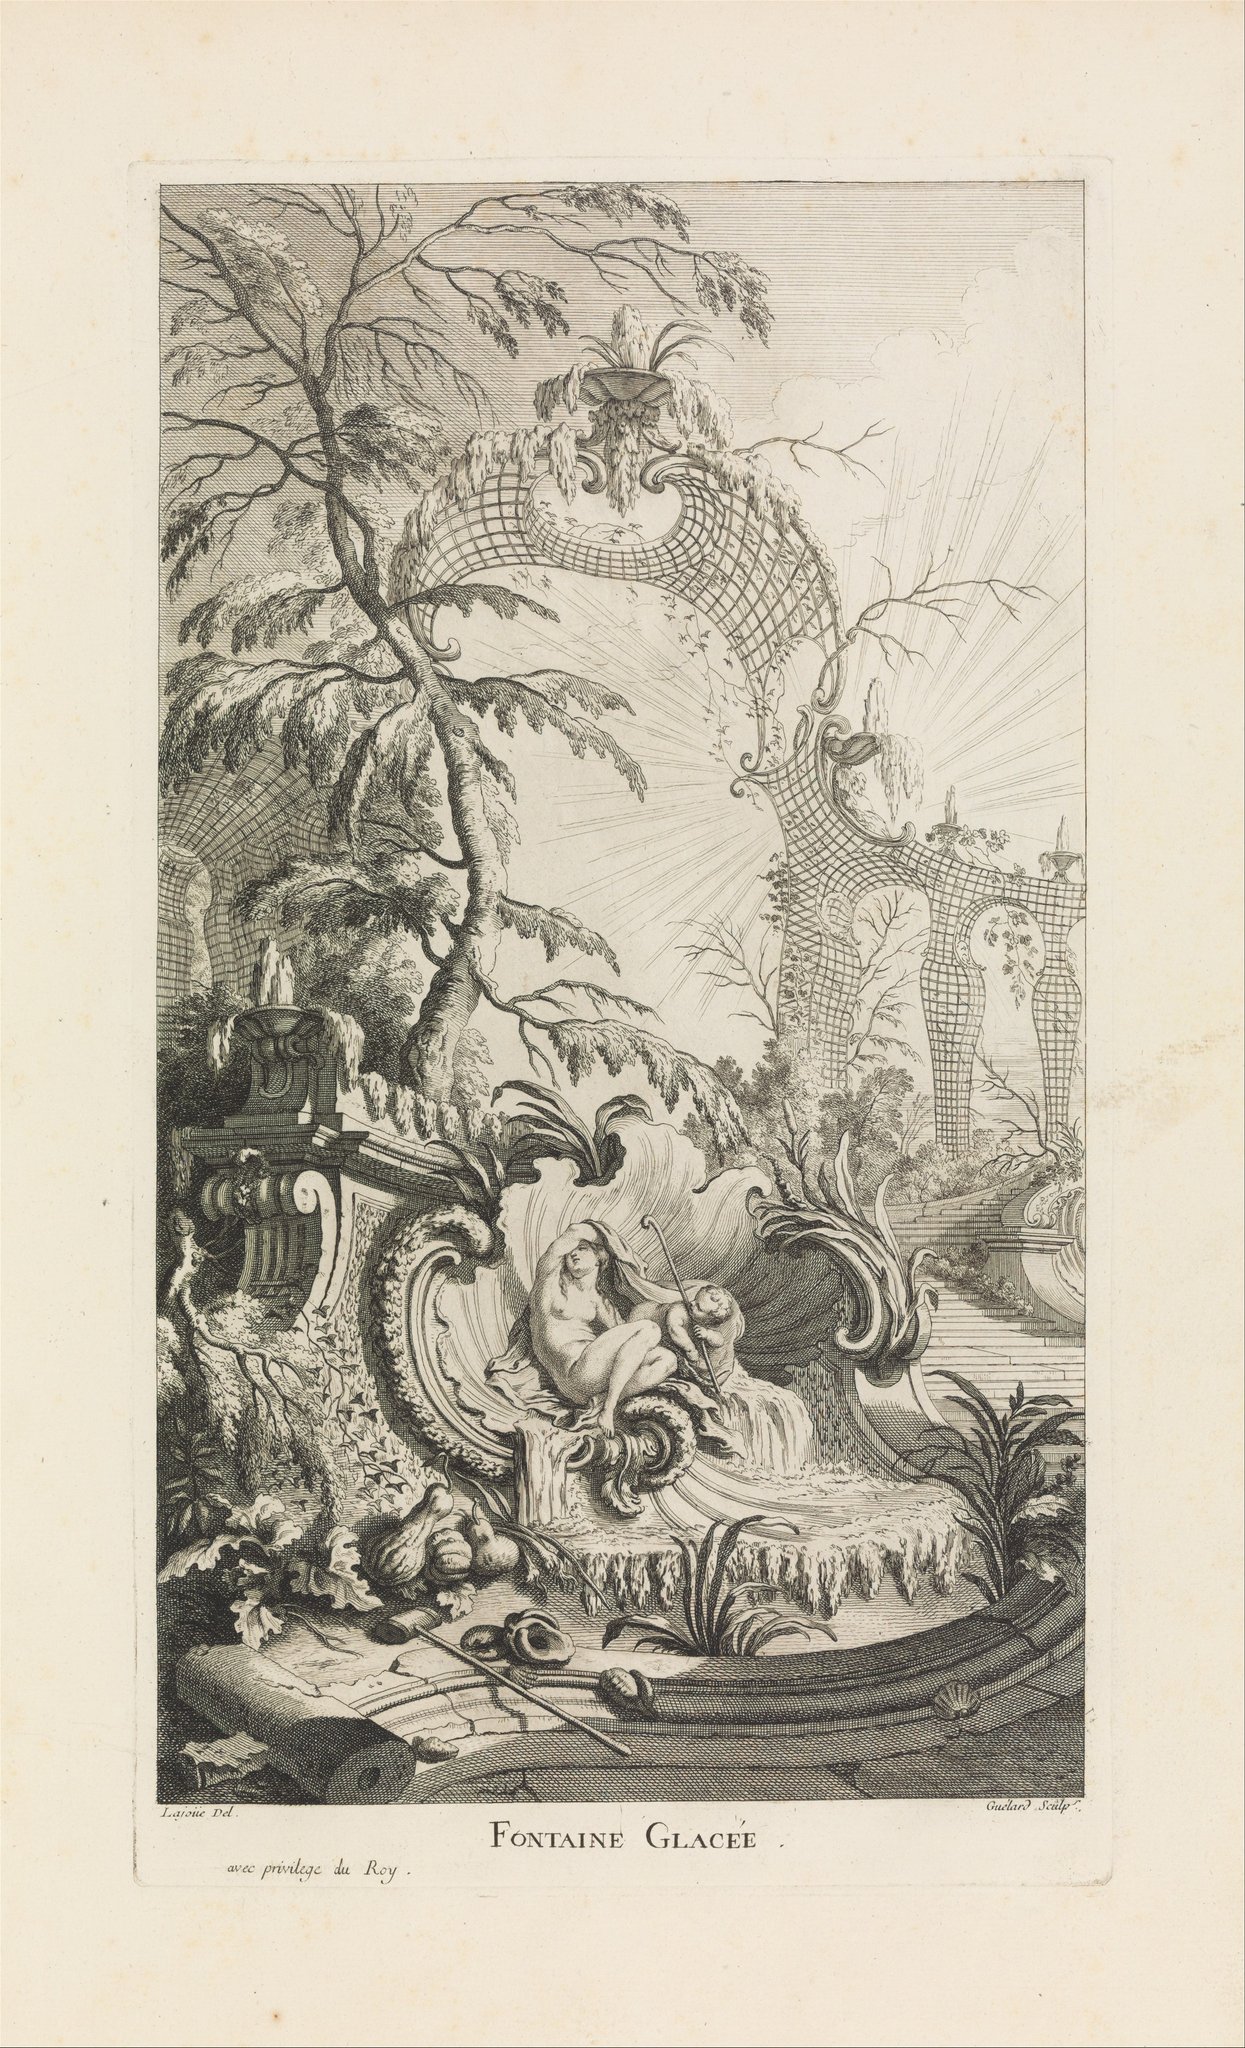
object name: book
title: New Book of Twelve Pieces of Fantasy useful for various purposes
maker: jacques de la joue the younger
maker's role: artist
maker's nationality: french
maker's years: 1686-1761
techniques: etching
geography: france